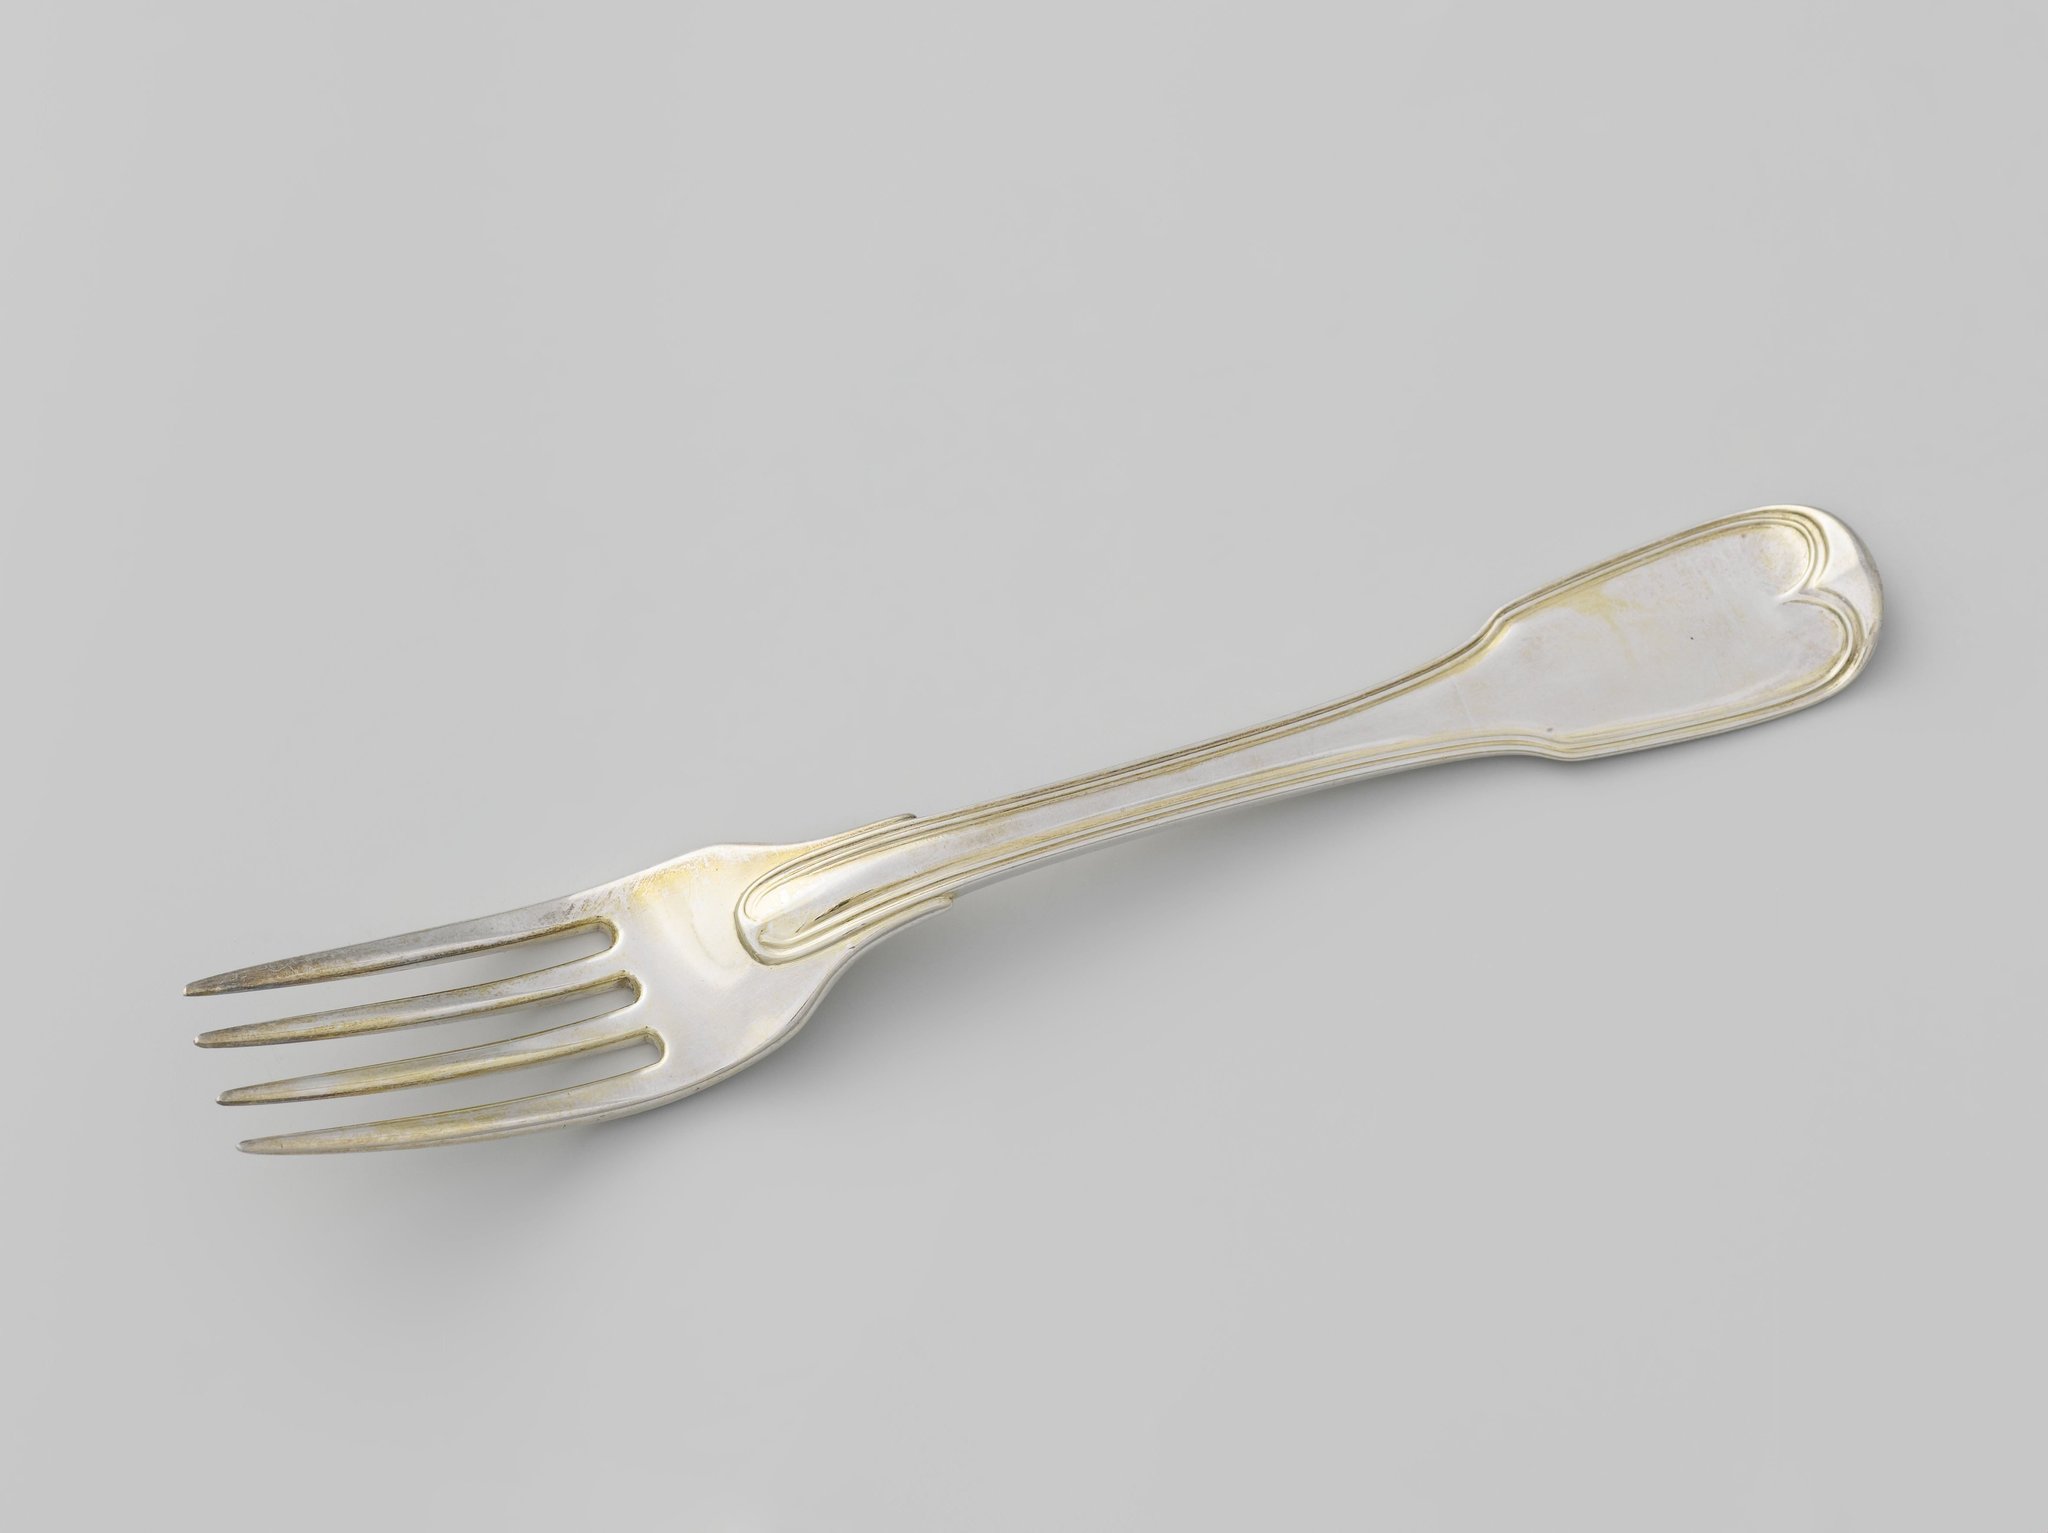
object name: fork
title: Vork met het helmteken Clifford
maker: hendrik helweg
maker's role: silversmith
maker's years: 1802-1858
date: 1832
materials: silver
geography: amsterdam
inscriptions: alloy mark: ‘leeuw 1ste gehalte’, hallmark: ‘Minervakop met A (keurkamer Amsterdam)’, maker's mark: ‘HH onder anker in vierkant’, date letter: ‘X (=1806)’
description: De viertandige vork is aan zowel boven- als onderzijde door middel van enkel lof verbonden met de platte, gebogen steel, die zich verbreedt naar het spatelvormige uiteinde. Boven- en onderzijde van de steel worden omgeven door een dubbele filetrand, die bij het uiteinde ingezwenkt is. Op de onderzijde van de spatel is het helmteken Clifford gegraveerd.